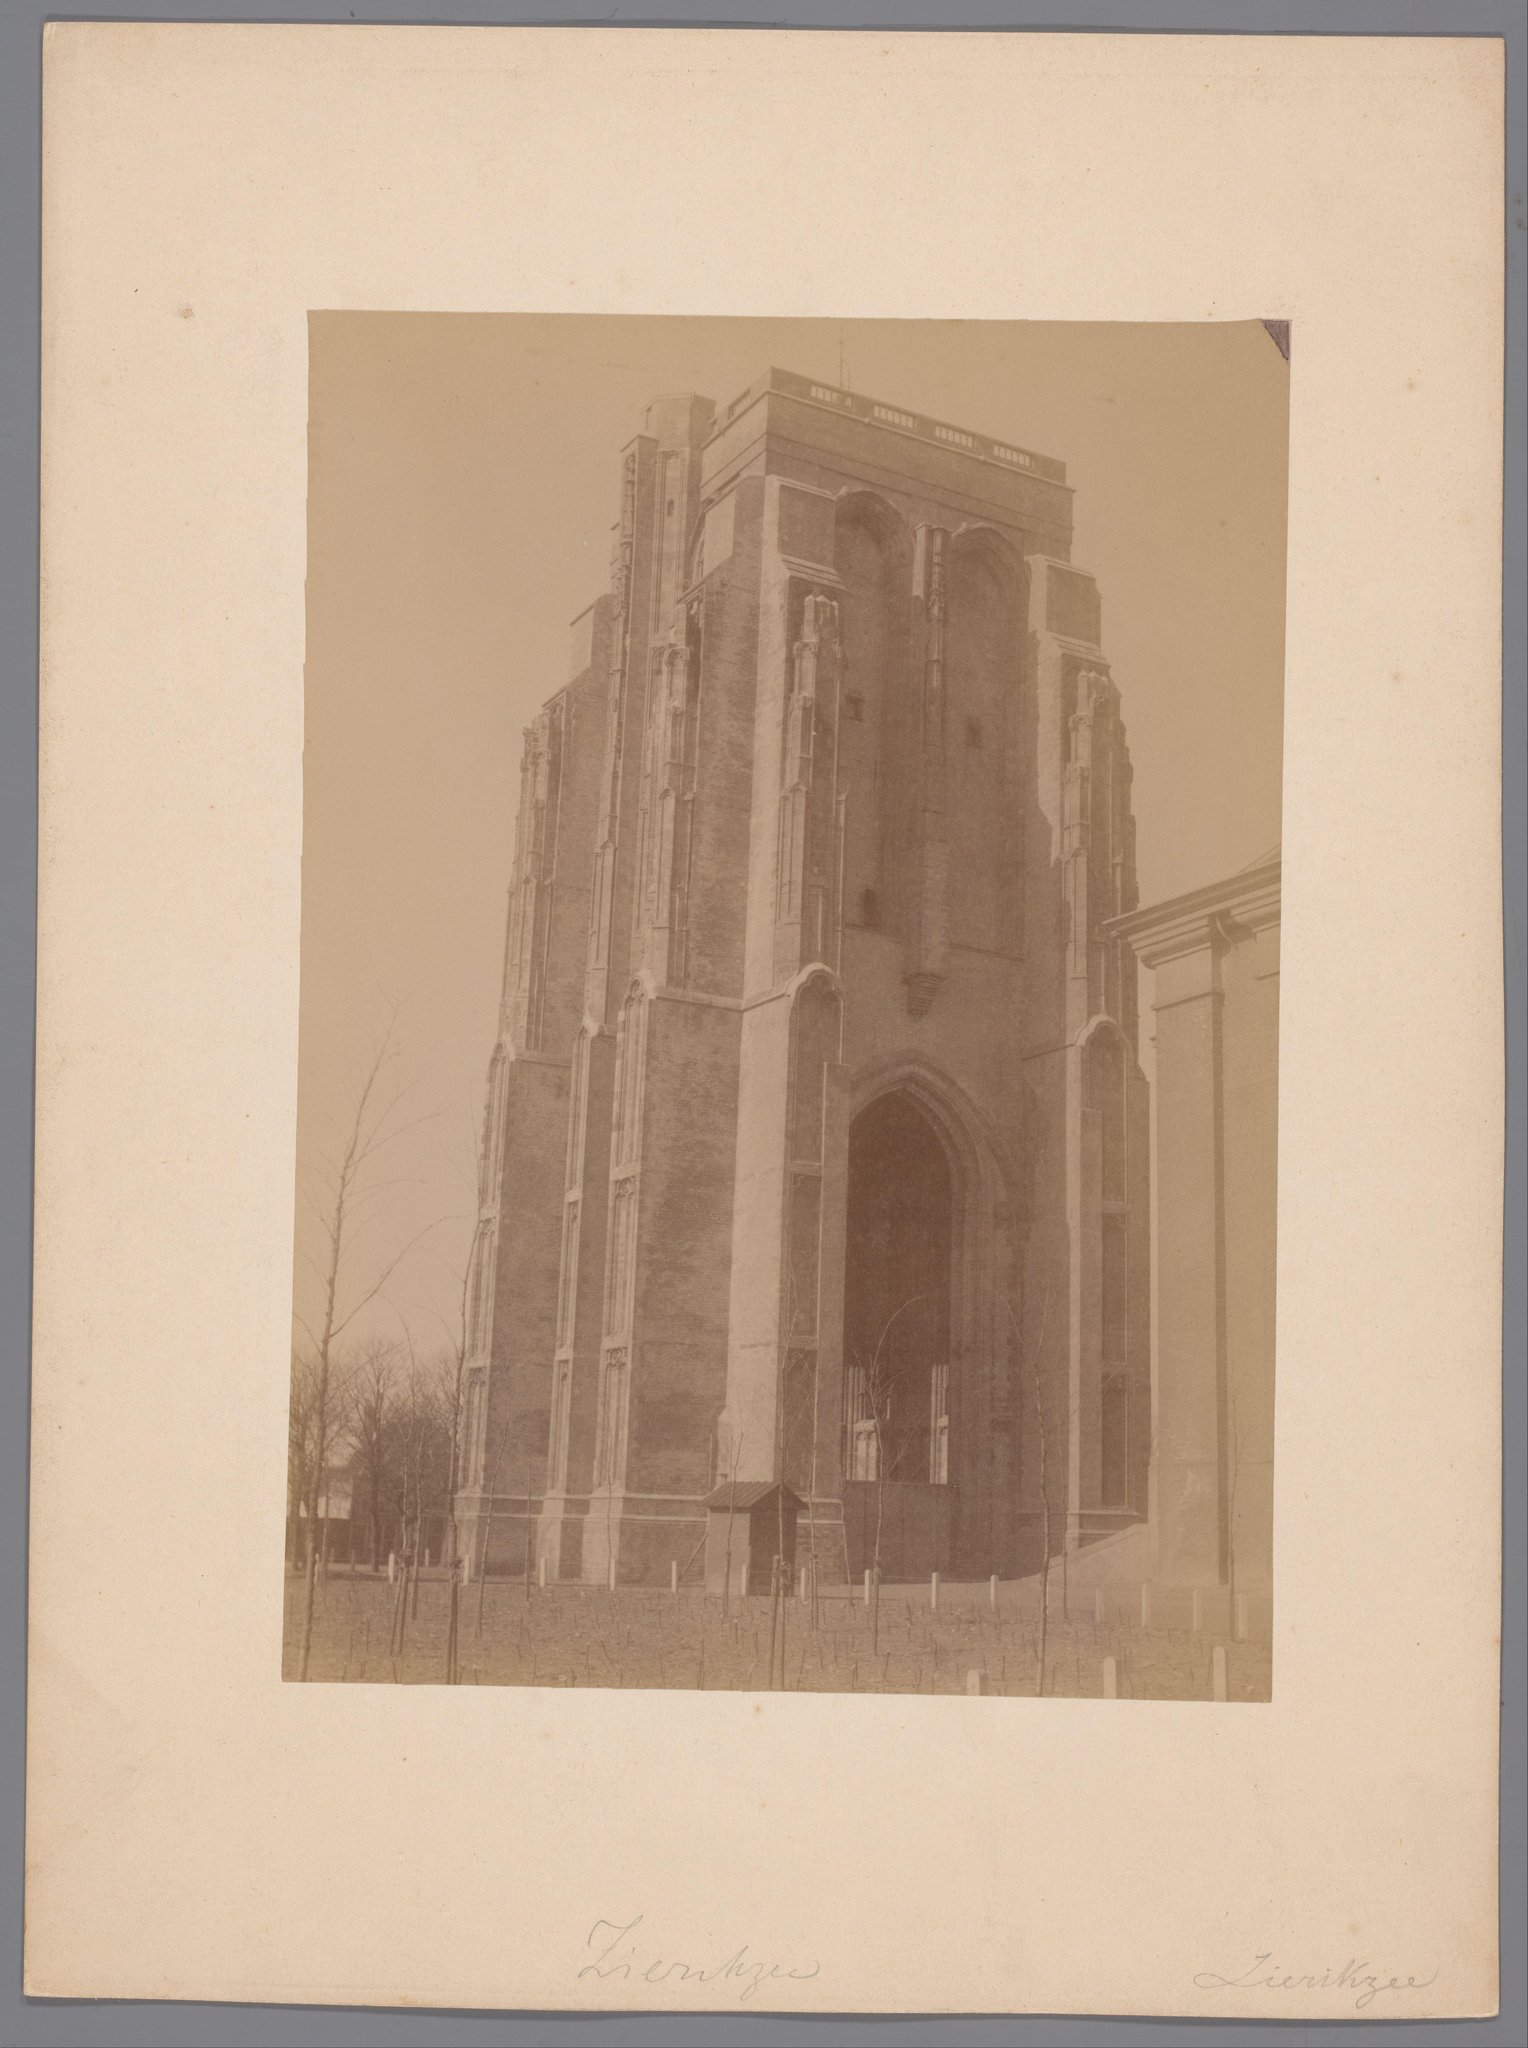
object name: photograph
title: Gezicht op de Sint-Lievensmonstertoren te Zierikzee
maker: anoniem (monumentenzorg)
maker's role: fotograaf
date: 1893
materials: cardboard, photographic support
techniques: albumen print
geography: zierikzee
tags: parts of church exterior and annexes: tower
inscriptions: annotation: ‘Zierikzee/ Zierikzee’, annotation: ‘Zierikzee/ Toren (Zuid-oostzijde) van de voormalige Groote- of St. Lievensmonsterkerk/ Maart 1893’